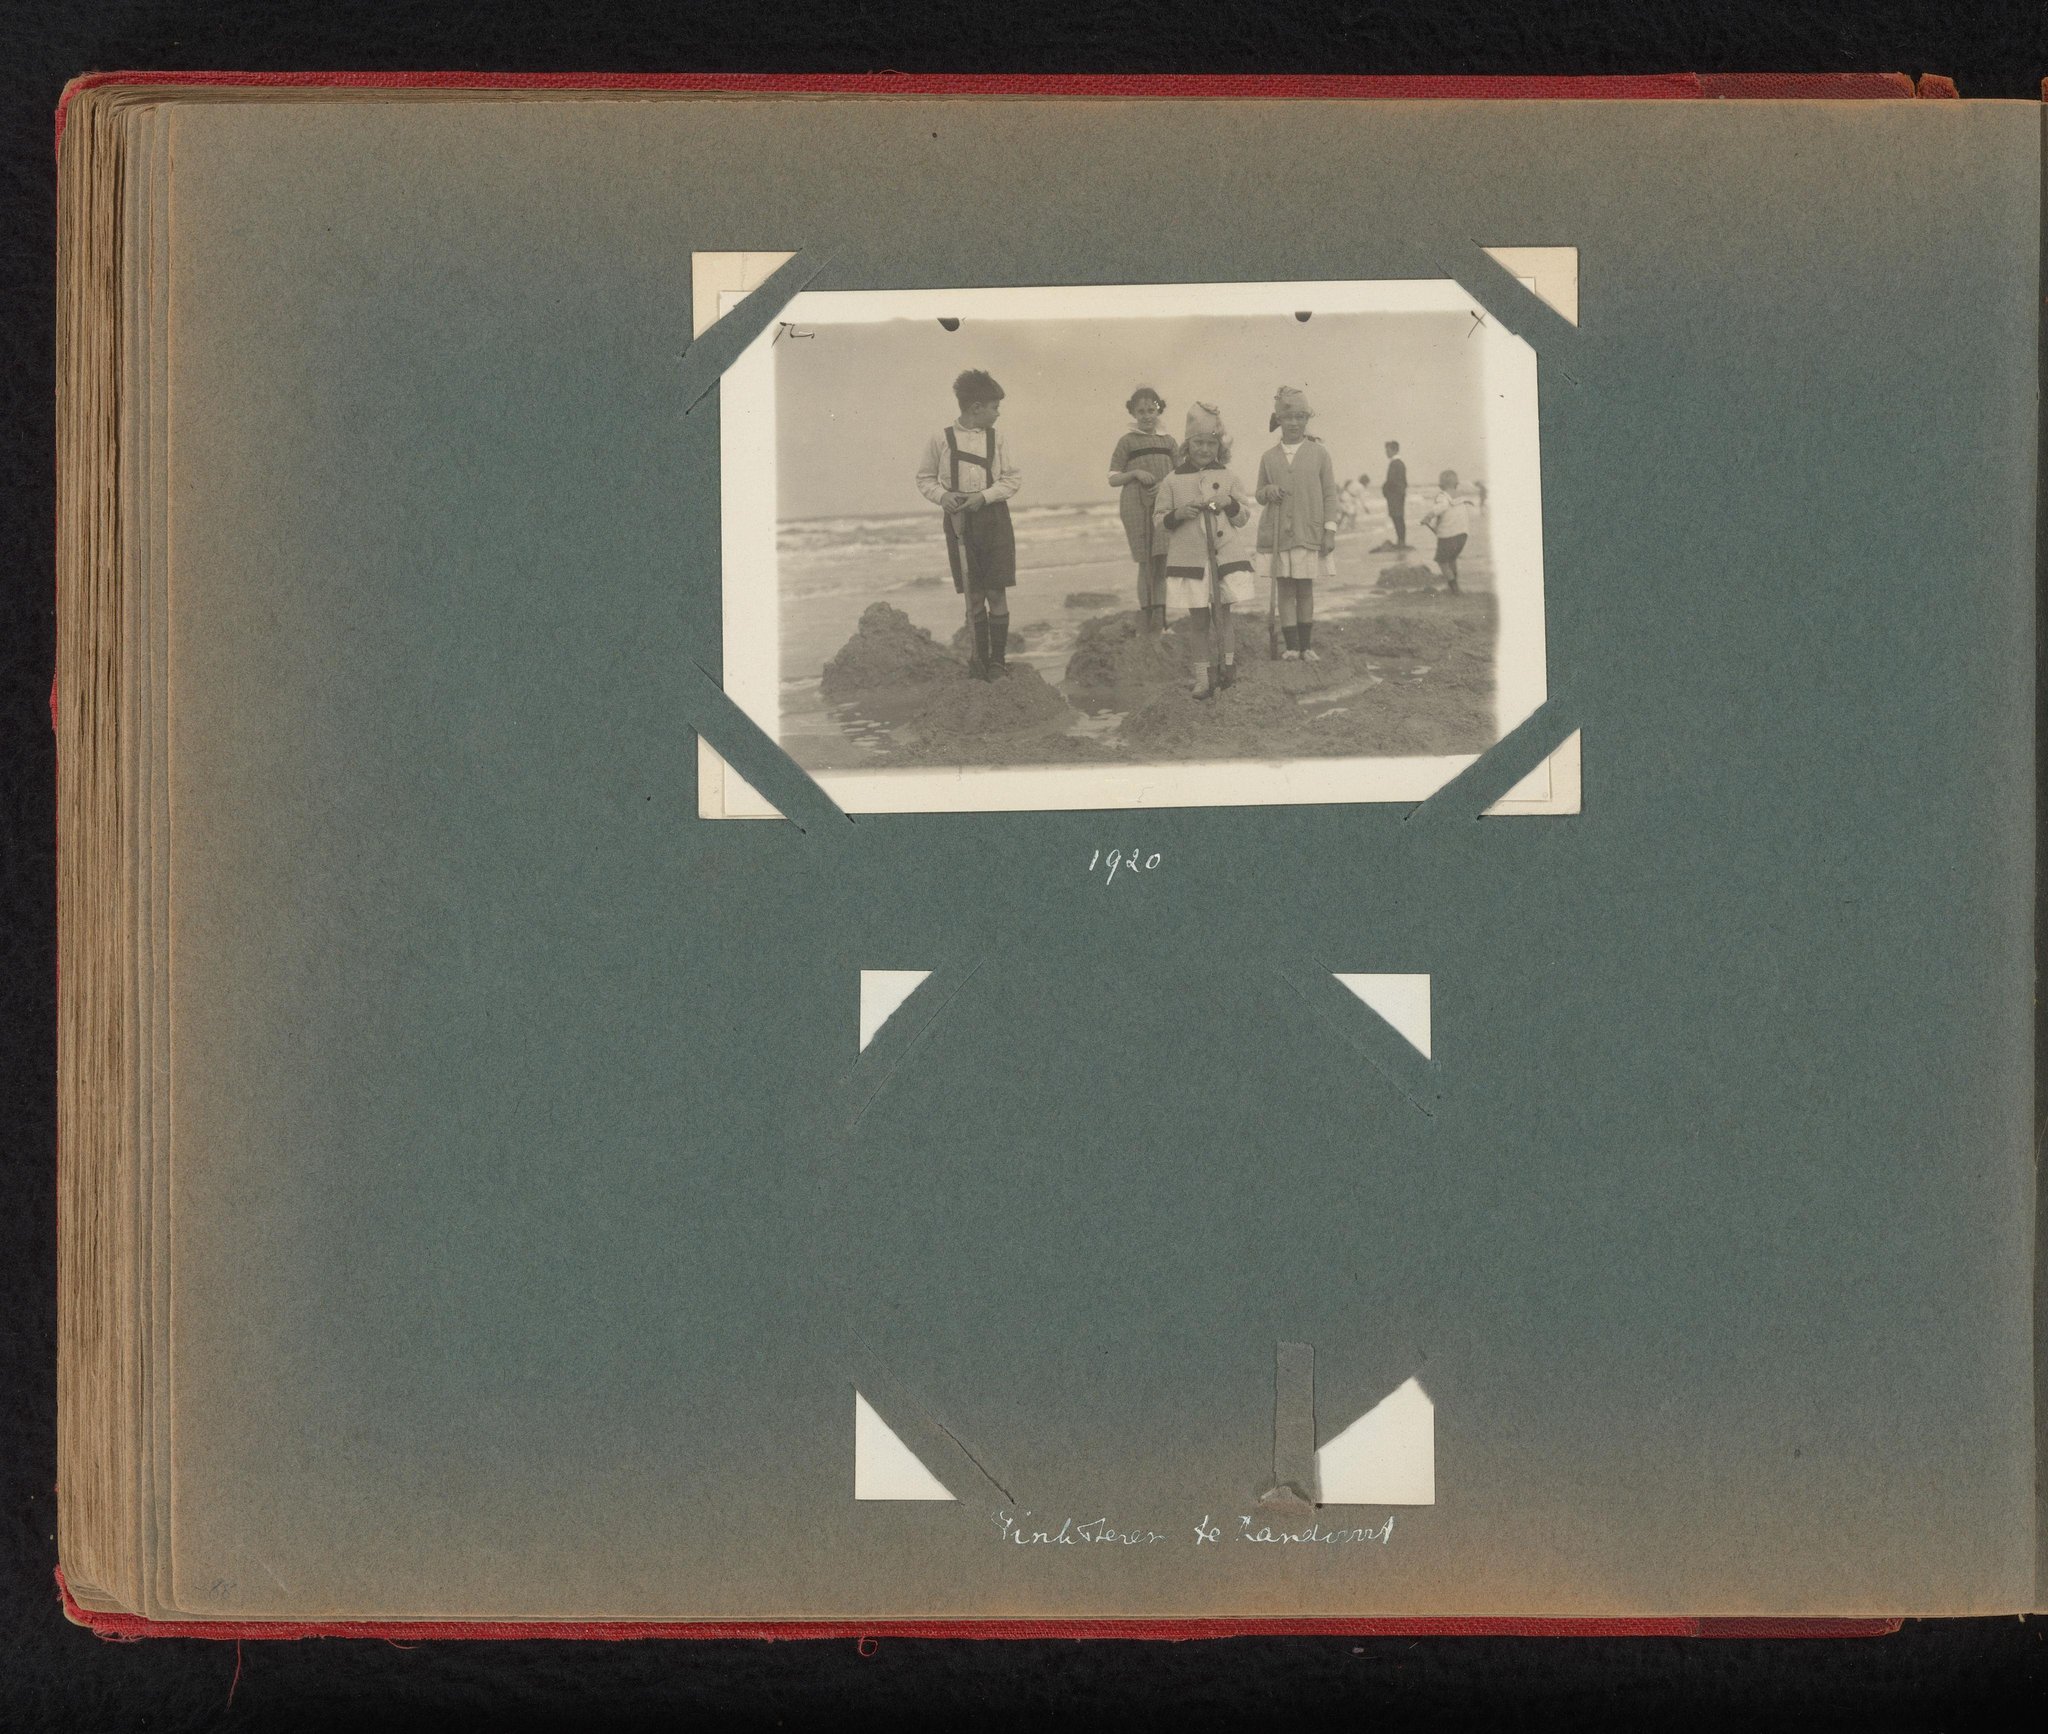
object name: photograph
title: Kinderen op het strand van Zandvoort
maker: charlotte alida boelen-matthes (lot)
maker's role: amateurfotograaf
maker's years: 1889-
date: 1920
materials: paper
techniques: gelatin silver print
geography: zandvoort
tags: beach (as place of recreation)